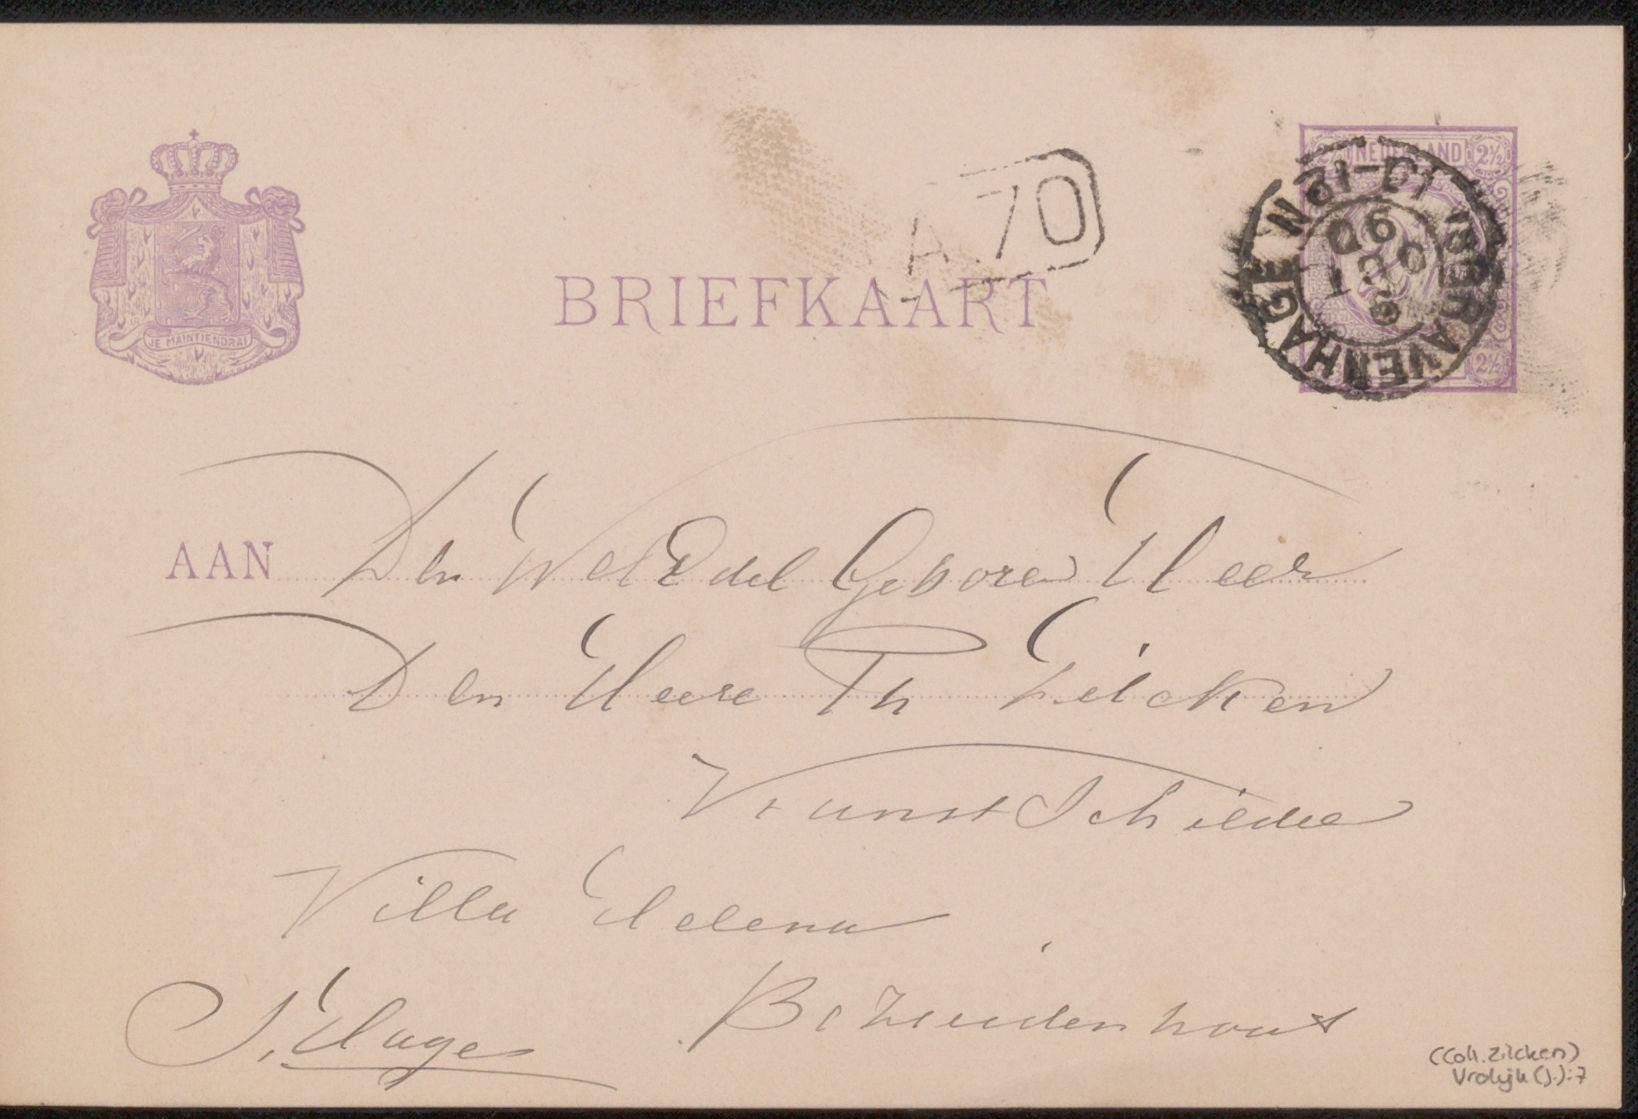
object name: postcard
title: Briefkaart aan Philip Zilcken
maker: jan vrolijk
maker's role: draughtsman, painter, print maker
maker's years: 1846-1894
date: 1890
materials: cardboard, ink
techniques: pen, writing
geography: the hague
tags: painter, draughtsman, philip zilcken, diseases